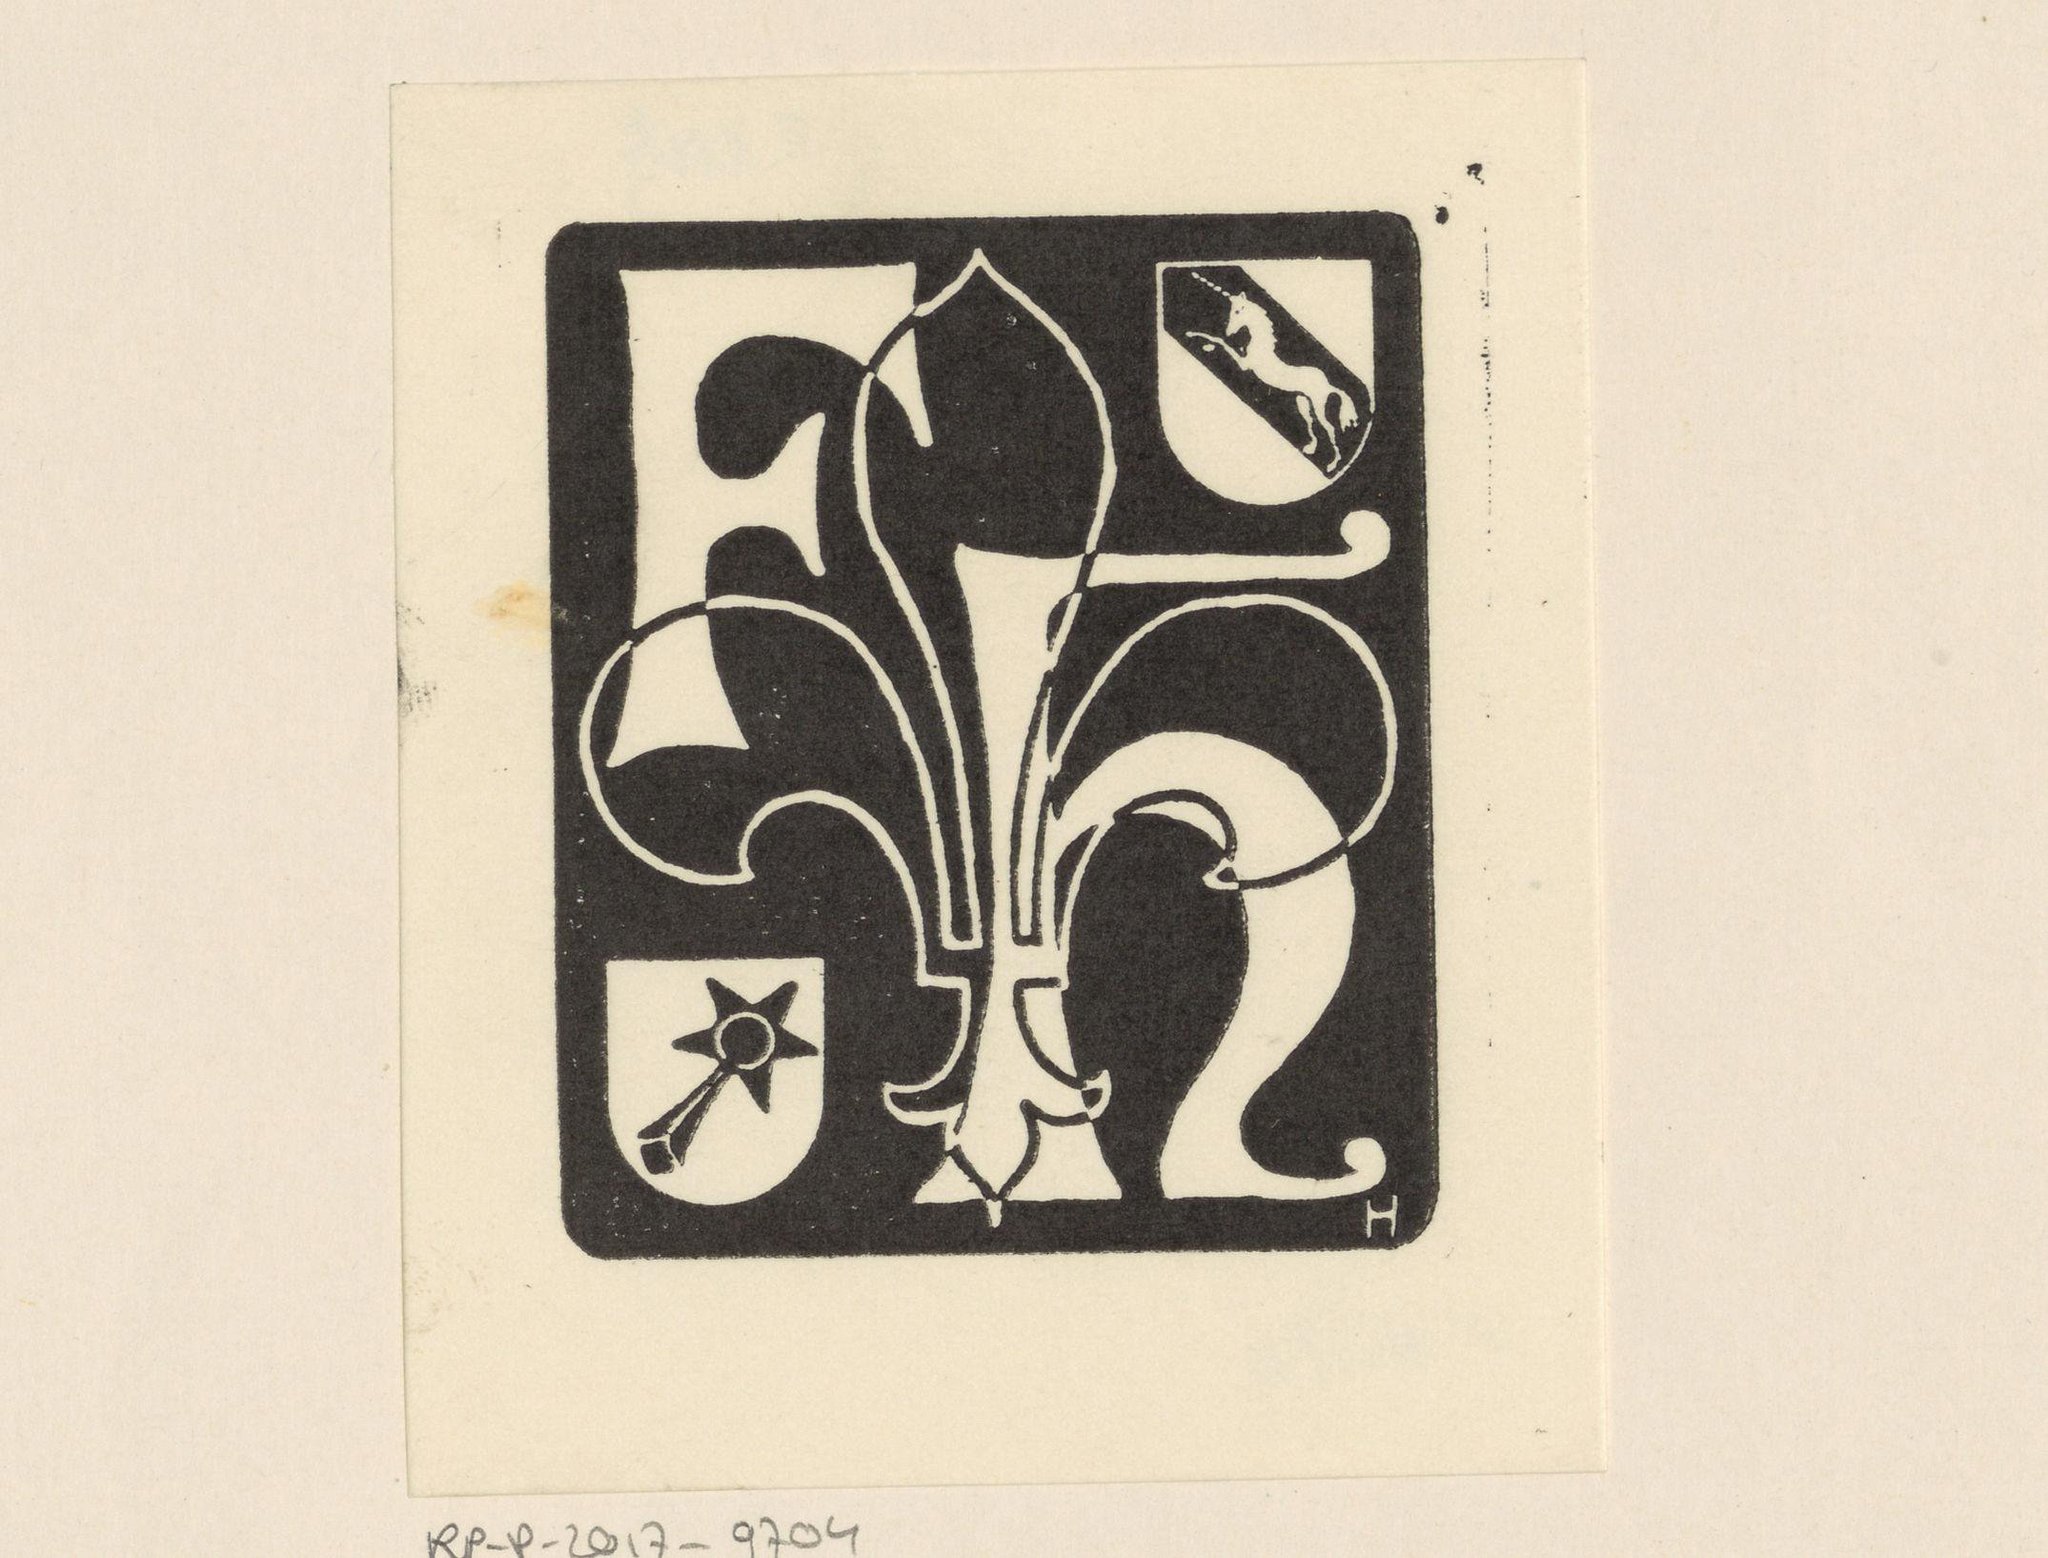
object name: bookplate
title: F.H.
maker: Anonymous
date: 1900-1999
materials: paper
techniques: woodcut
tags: fleur-de-lis ~ ornament, unicorn, armorial bearing, heraldry